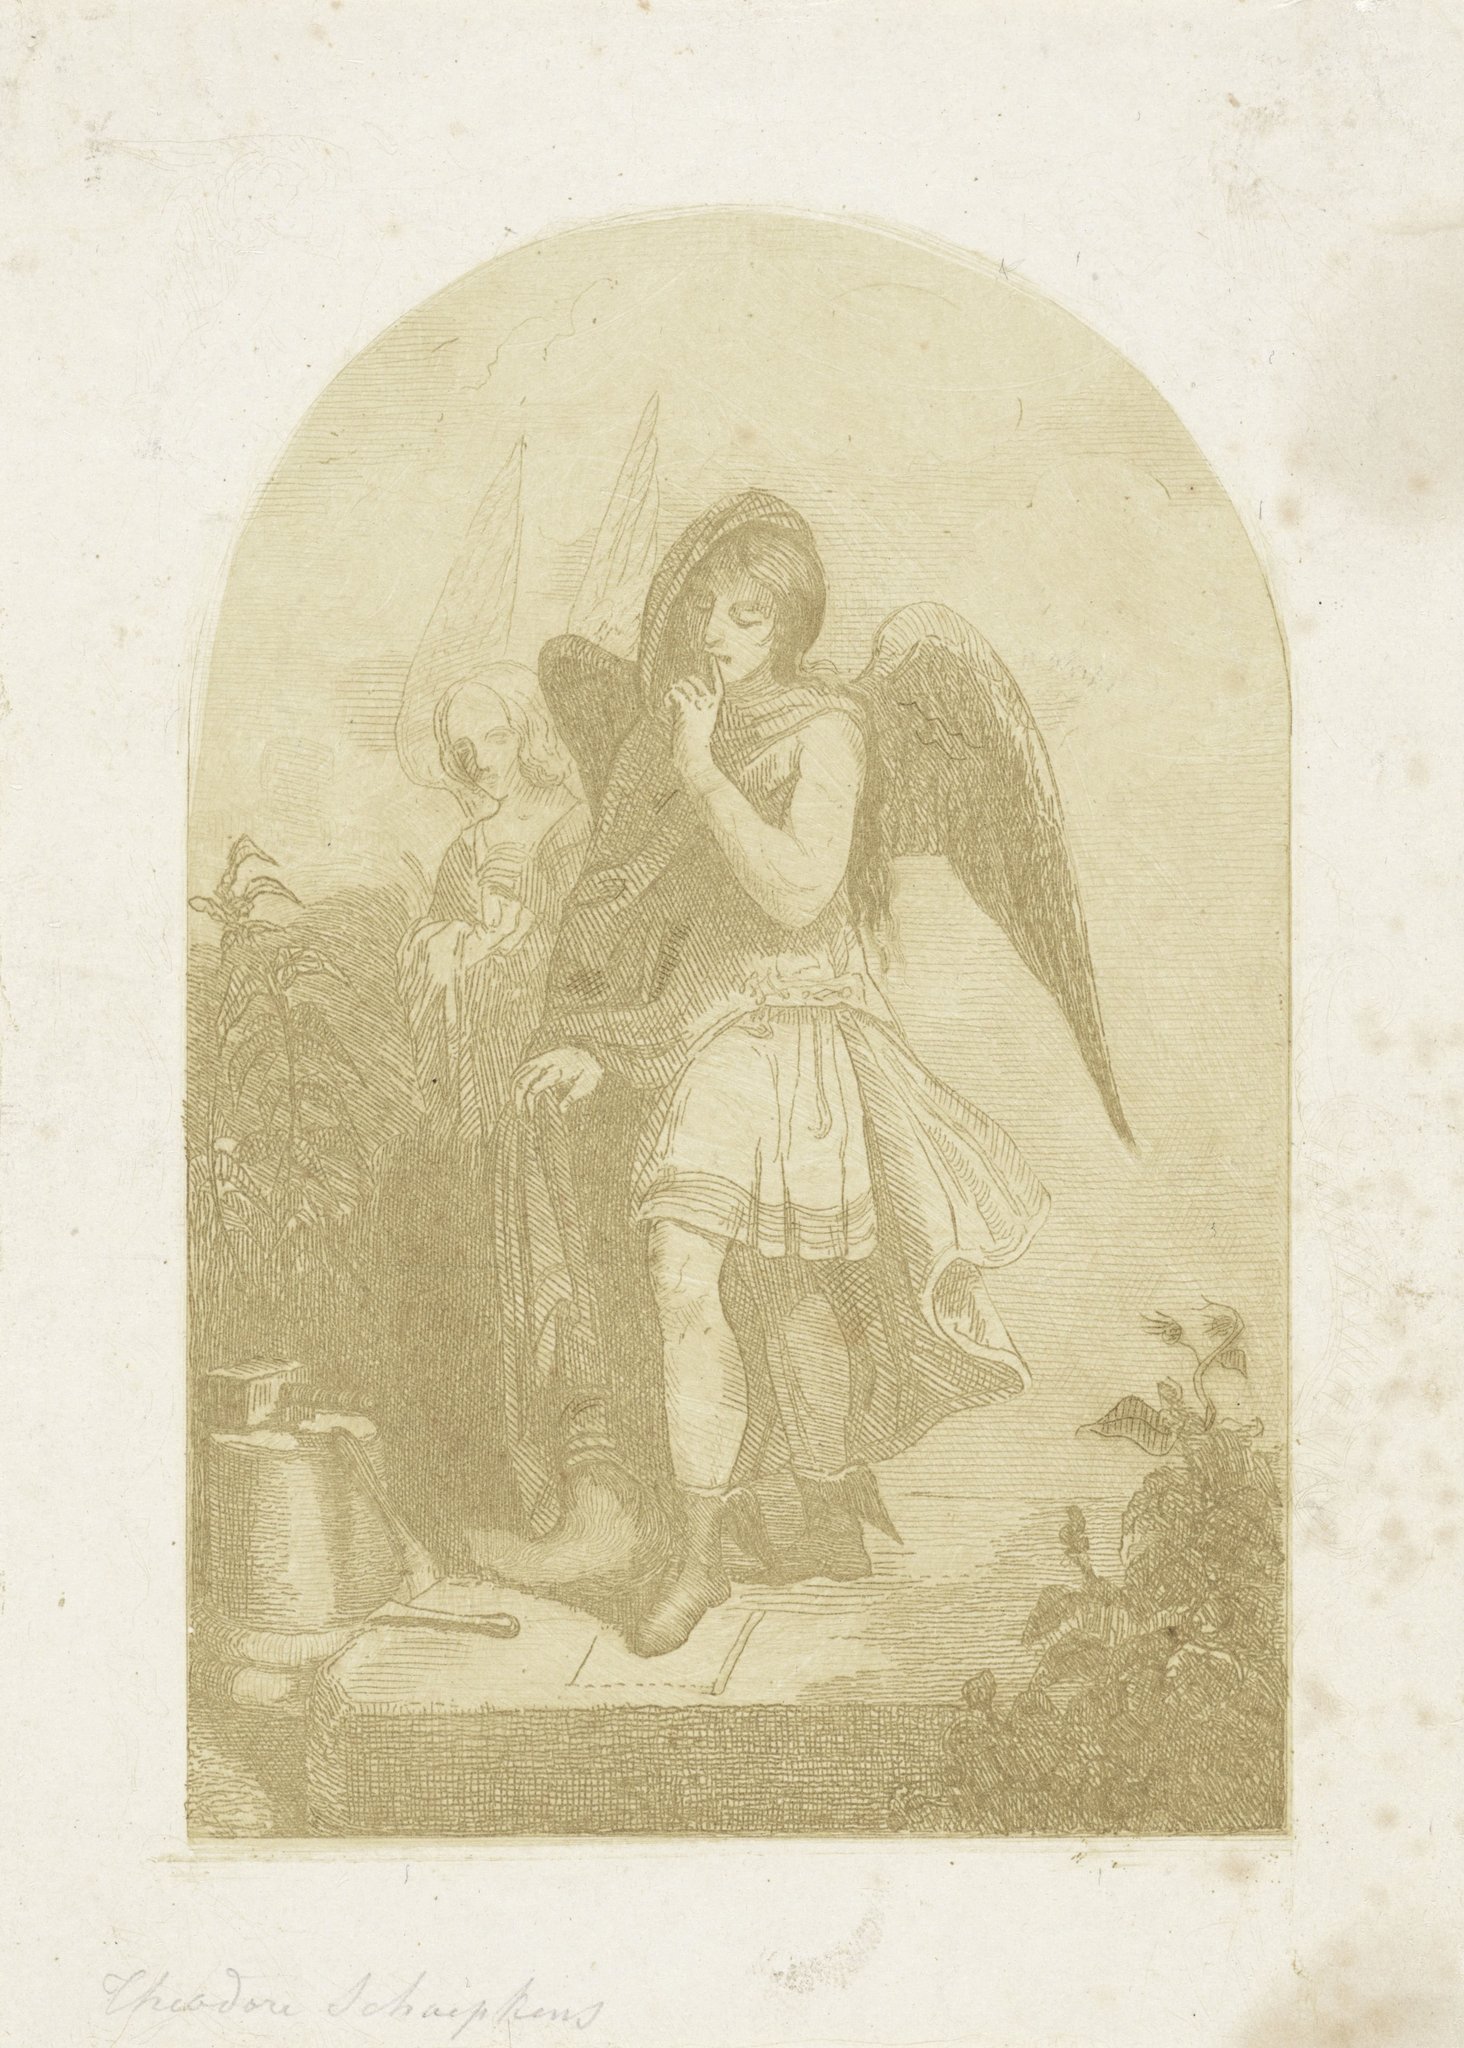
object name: print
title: Twee staande engelen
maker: theodoor schaepkens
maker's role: draughtsman, print maker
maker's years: 1810-1883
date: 1825-1883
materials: paper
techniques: etching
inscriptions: collector's mark: Lugt 2228